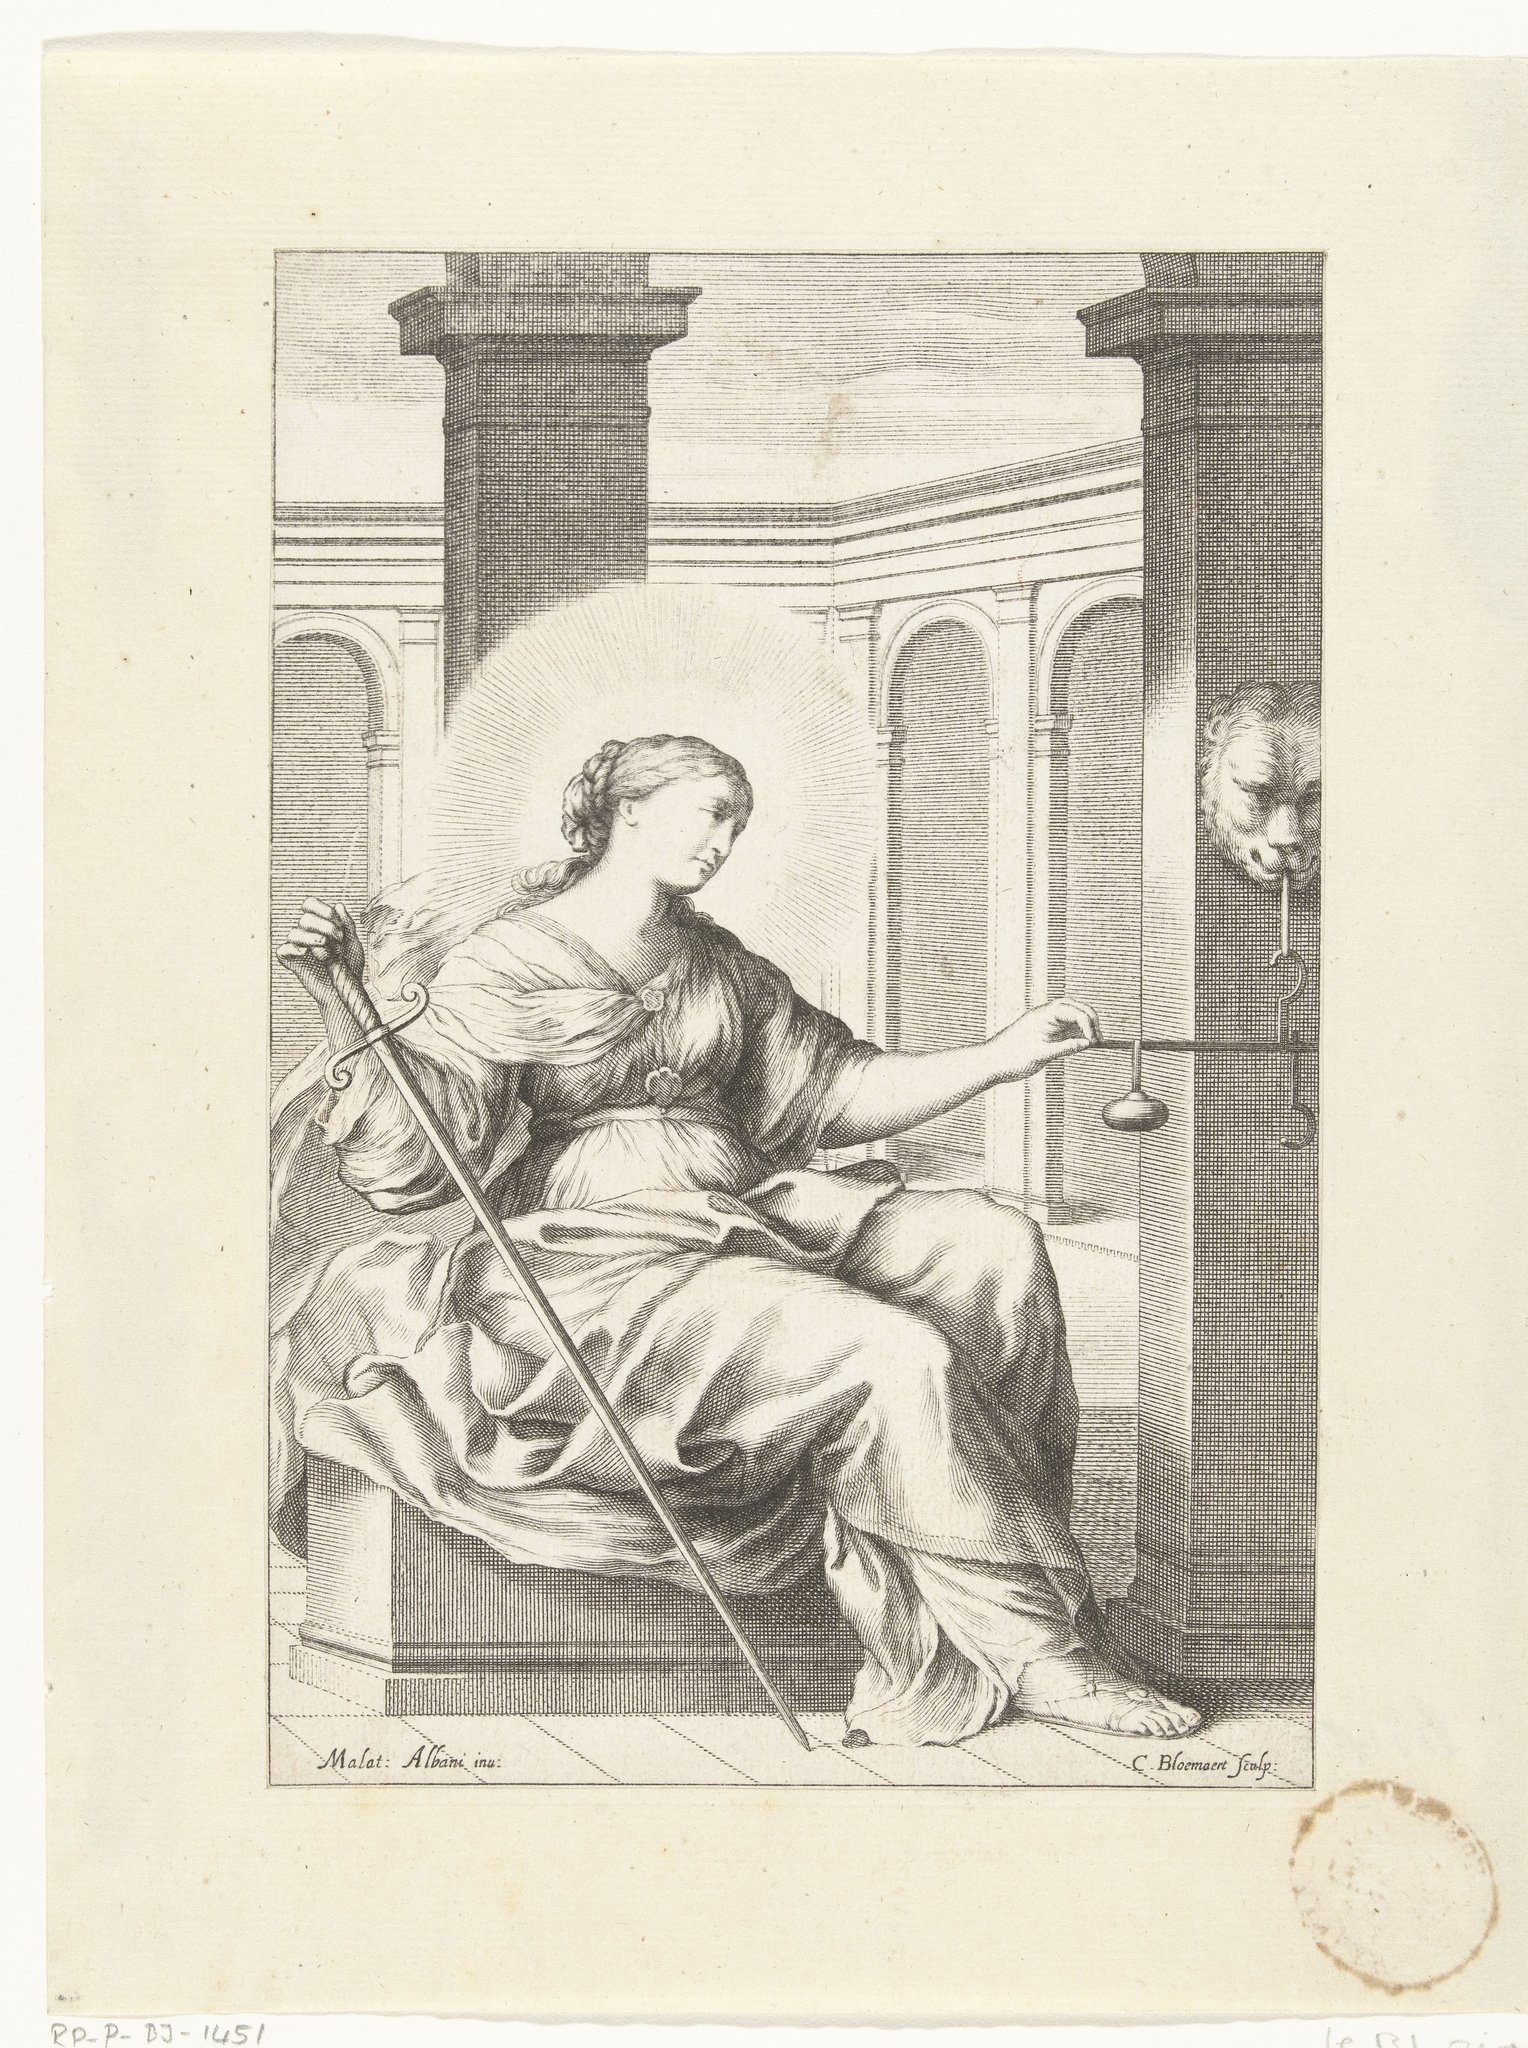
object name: print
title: Gerechtigheid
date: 1640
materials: paper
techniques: engraving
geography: rome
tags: justice, 'justitia'; 'giustitia divina' (ripa) ~ one of the four cardinal virtues, scales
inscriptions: collector's mark: Lugt 240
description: Een vrouw houdt in de rechterhand een zwaard en met de linkerhand ondersteunt zij een weegschaal. Illustratie voor het hoofdstuk Sotto Giustizia uit het boek Documenti d'Amore.